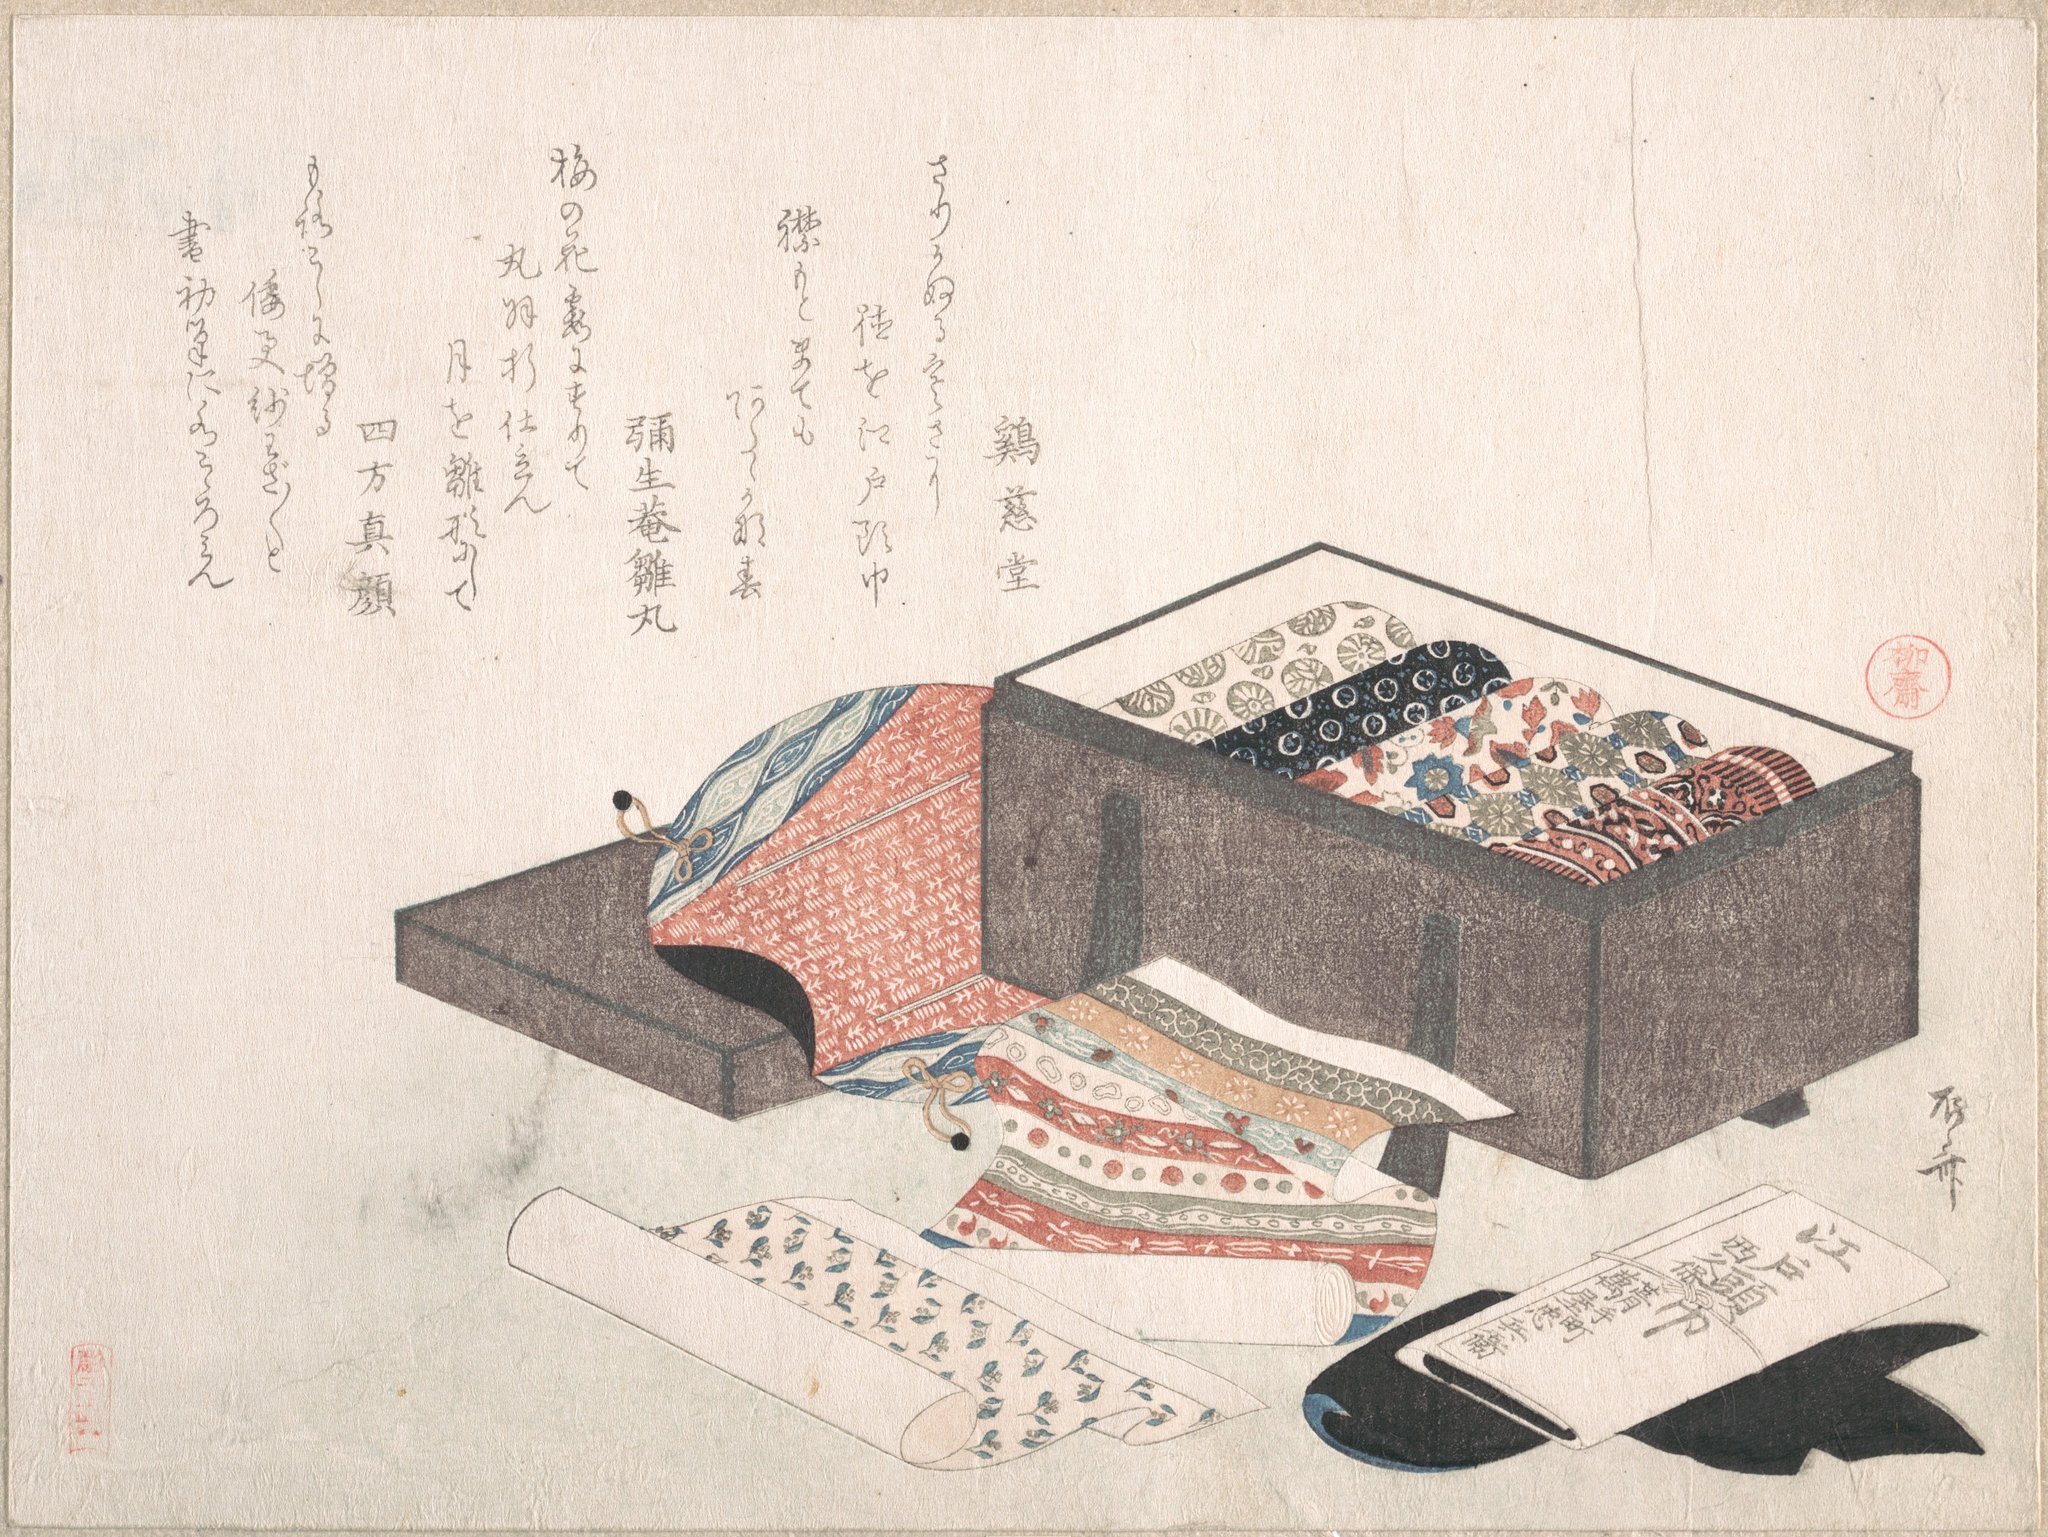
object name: woodblock print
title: Box with Draperies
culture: japanese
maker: ryūryūkyo shinsai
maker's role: artist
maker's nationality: japanese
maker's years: 1799-1823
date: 1801-1900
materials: ink, paper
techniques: surimono, woodblock print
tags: textiles